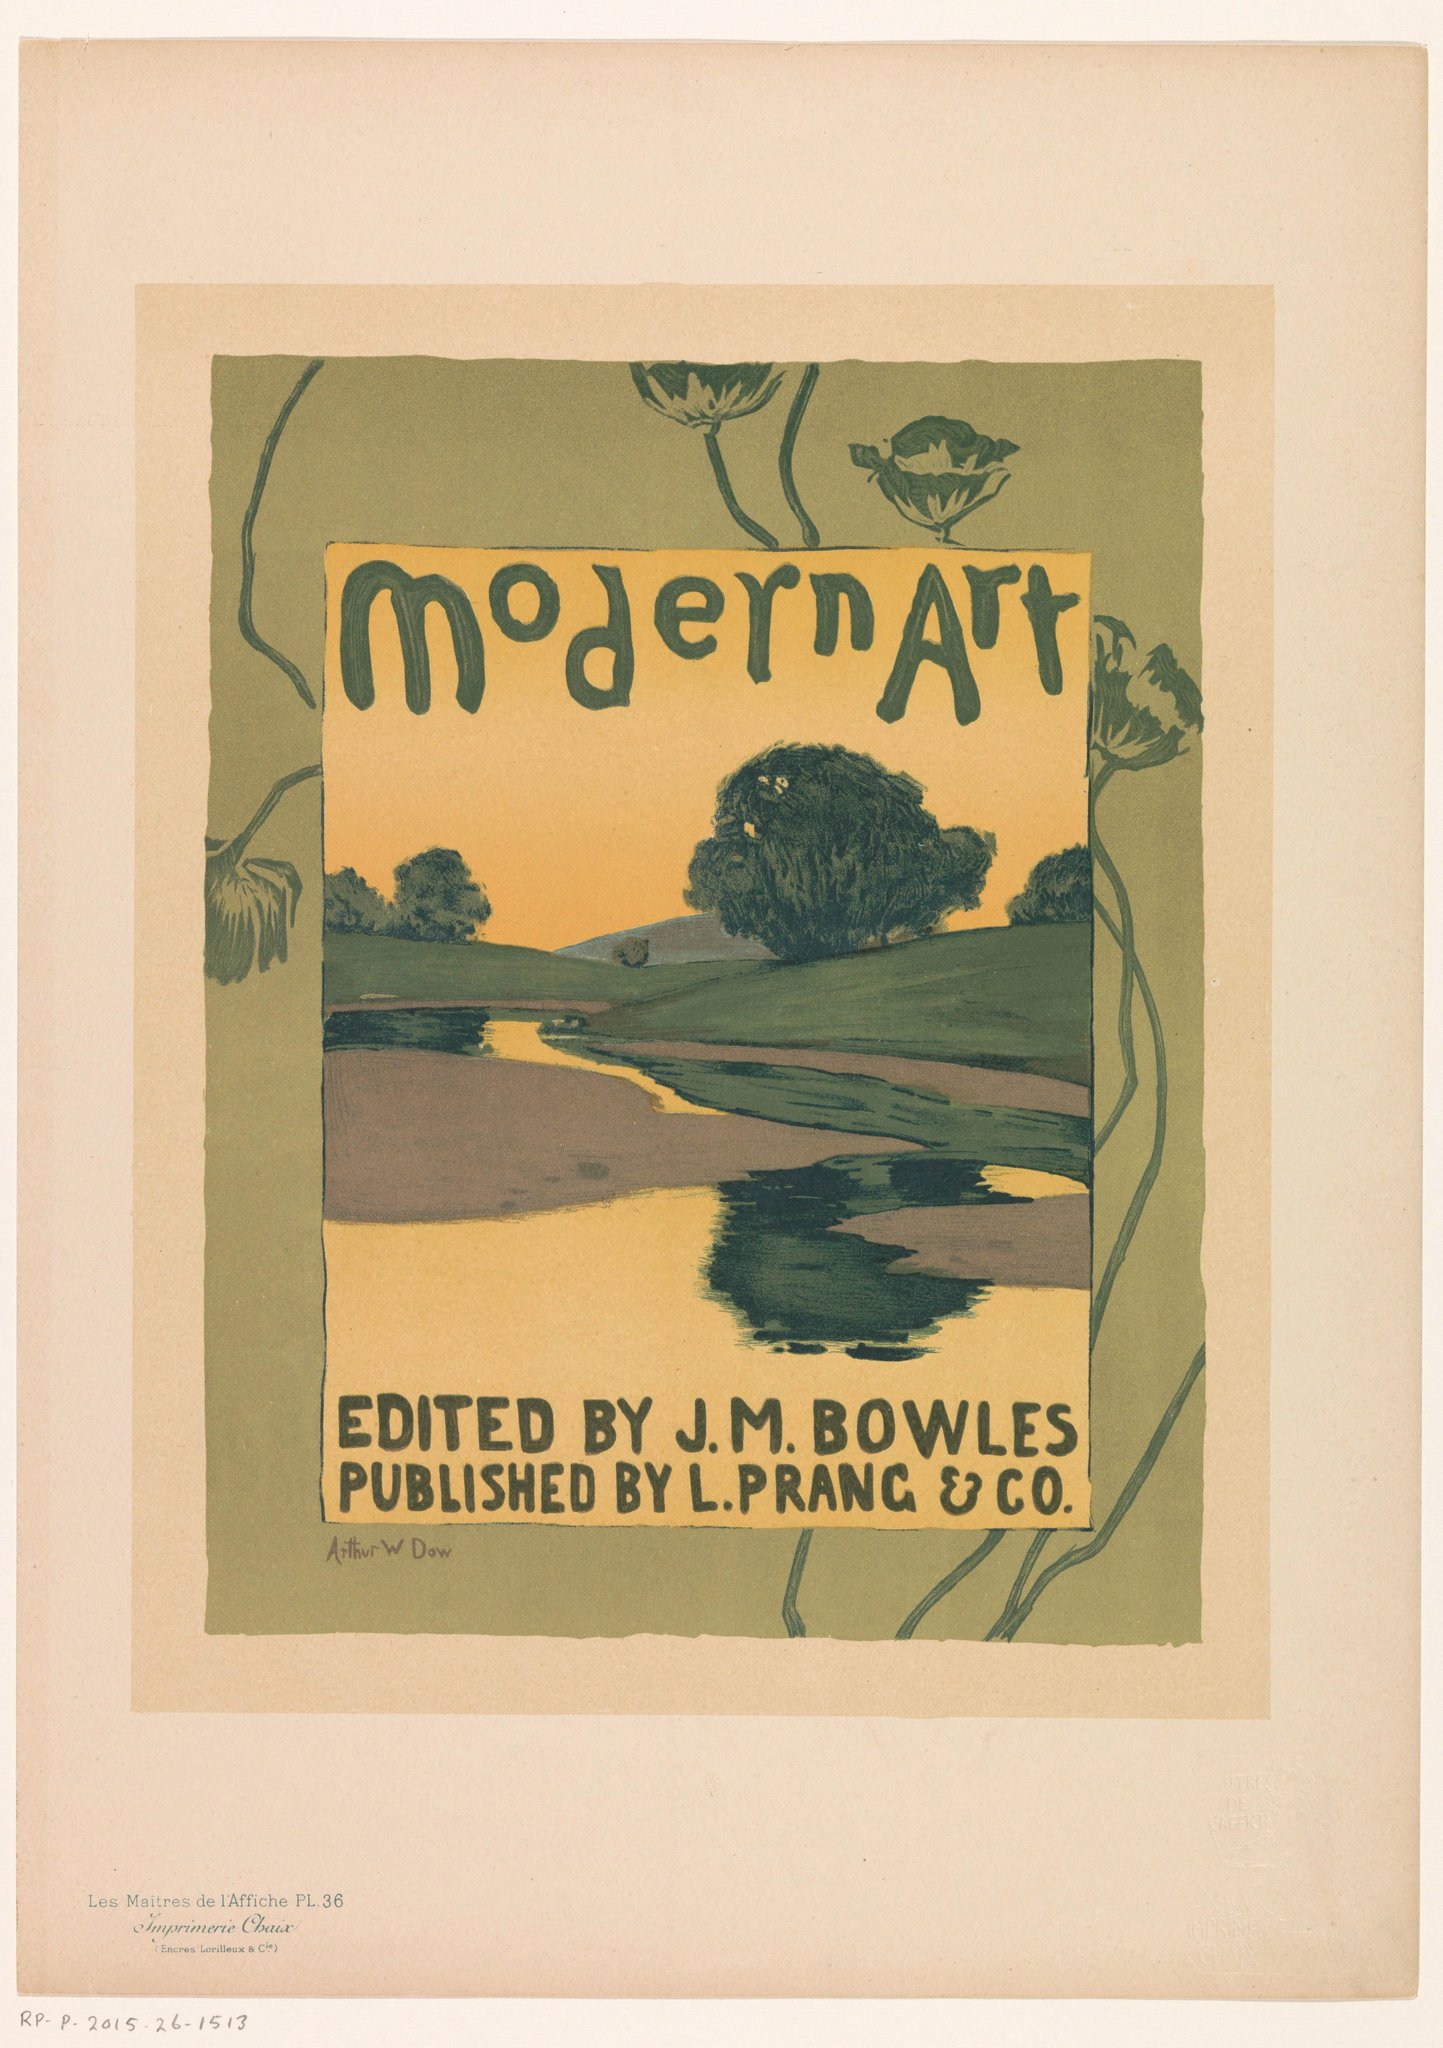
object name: print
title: Advertentie voor het tijdschrift Modern Art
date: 1895-1900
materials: paper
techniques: lithograph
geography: paris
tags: landscapes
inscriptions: collector's mark: Lugt 4780, stamp: Lugt 1777c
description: Landschap met een boom die wordt weerspiegeld in het water.